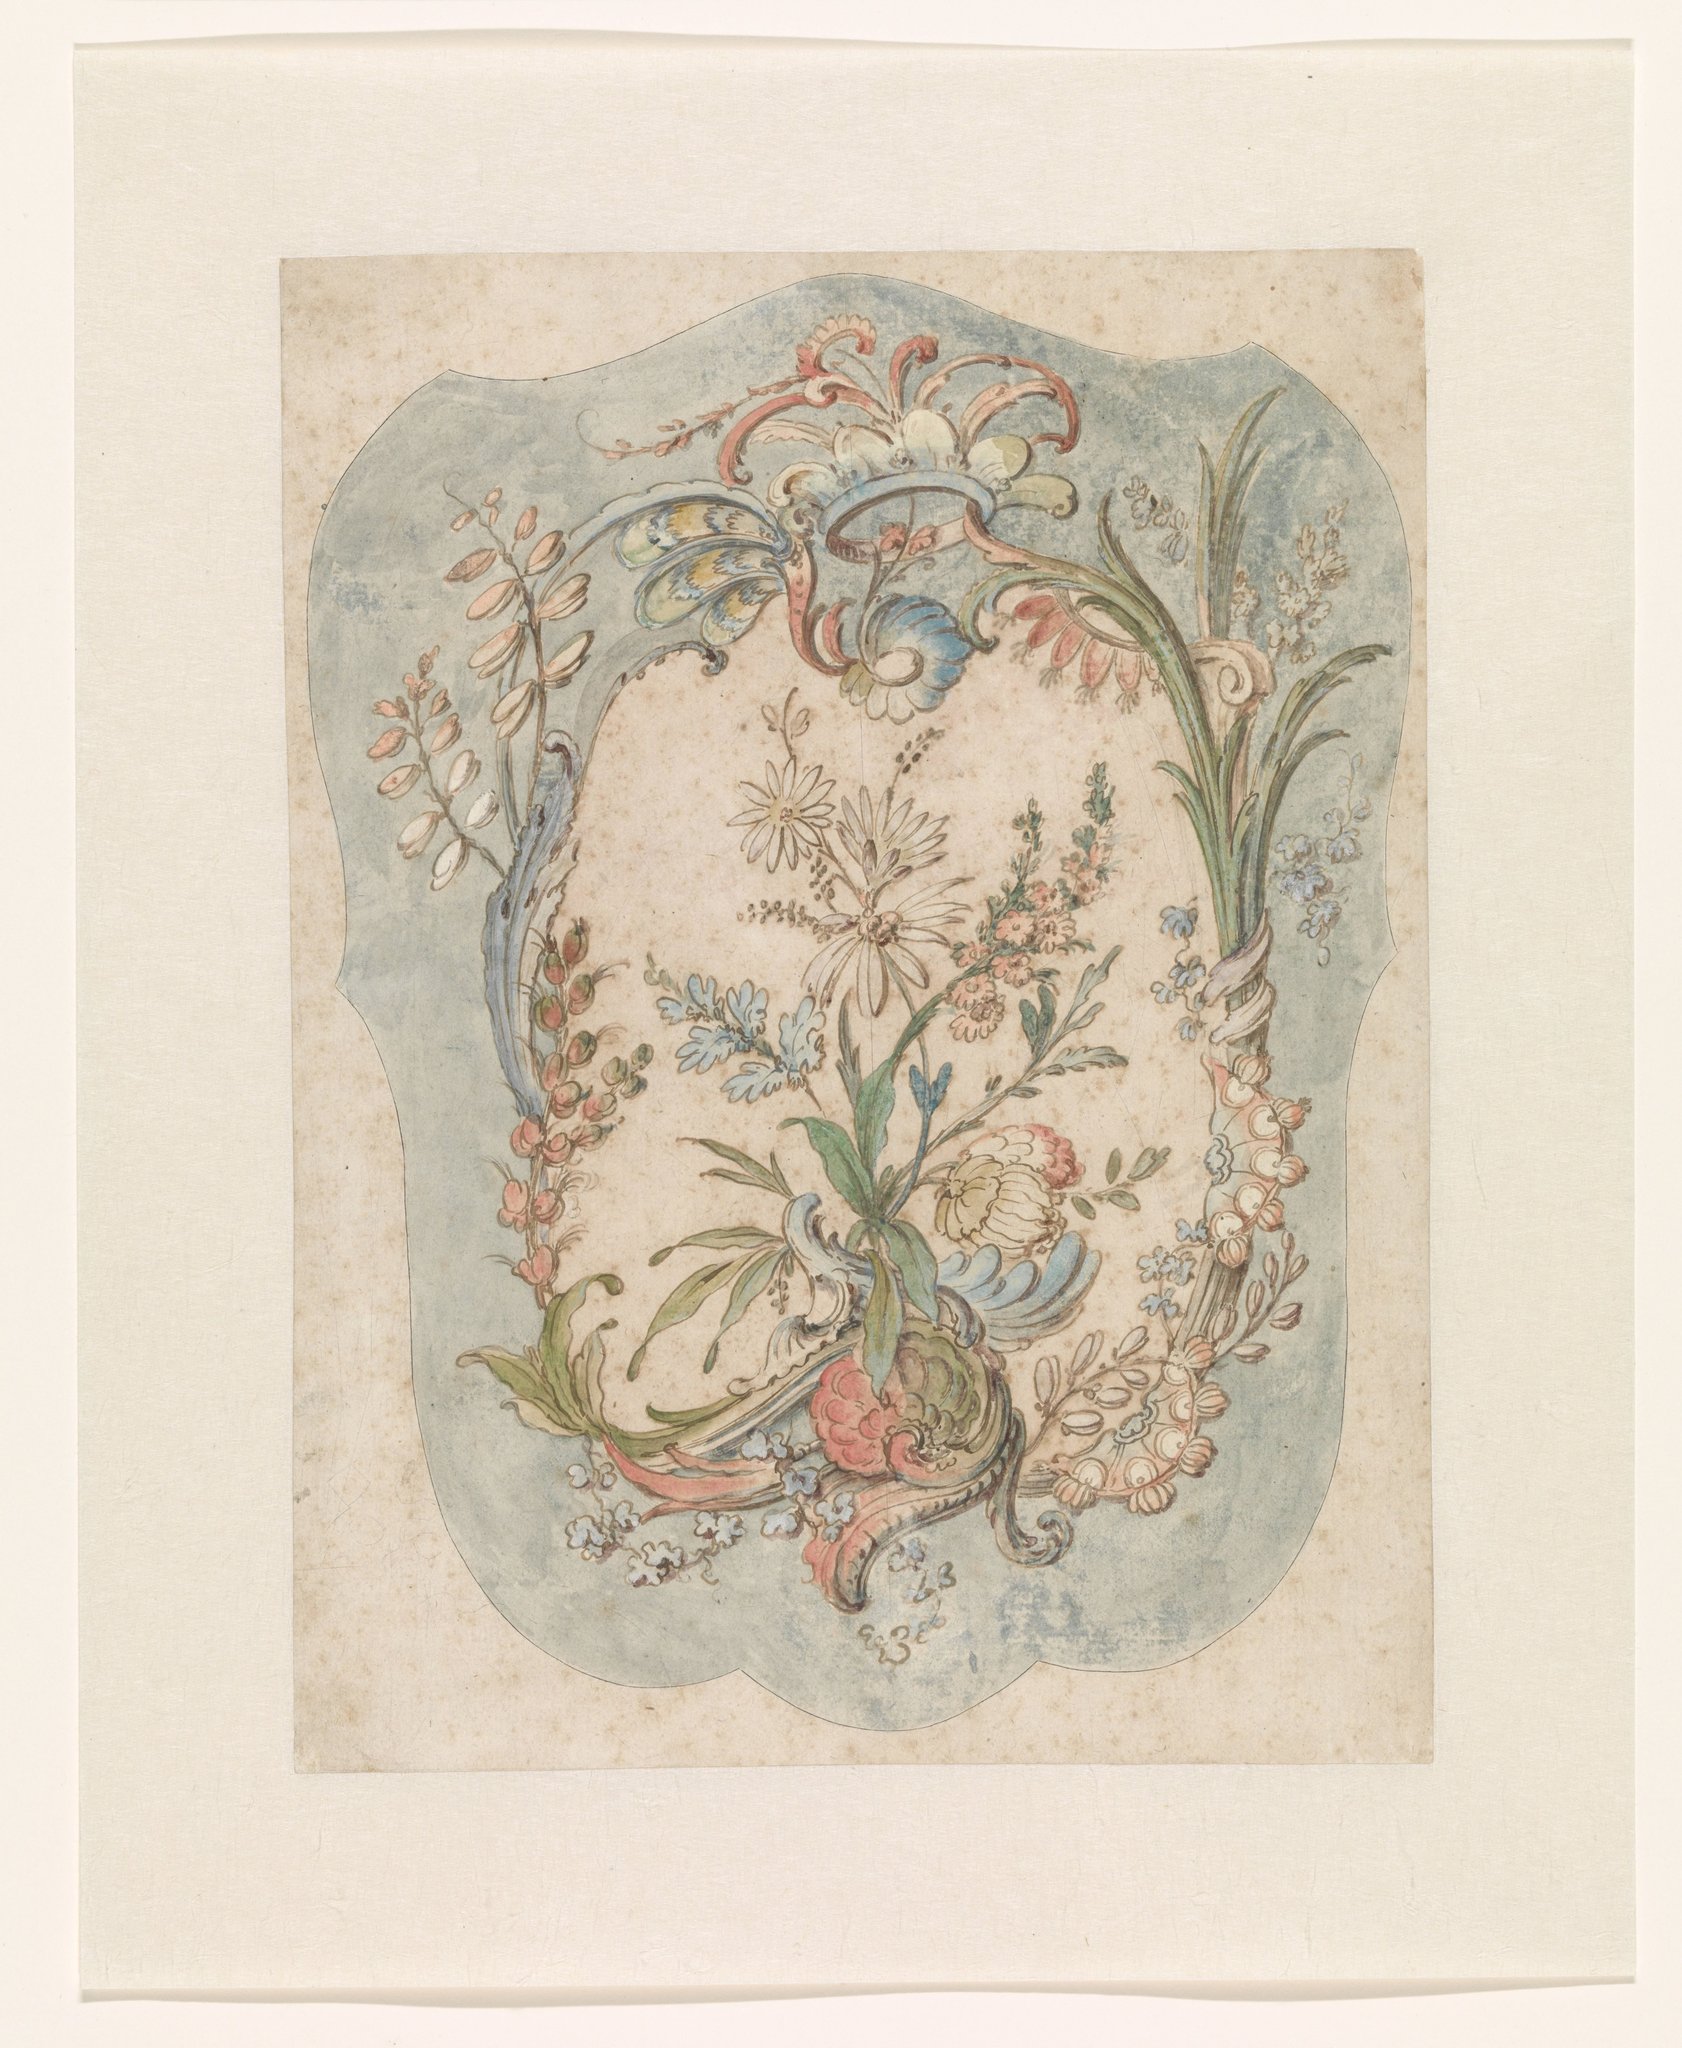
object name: design drawing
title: Design for a hand-screen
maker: gabriel huquier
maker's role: painter, print maker, publisher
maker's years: 1695-1772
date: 1738-1749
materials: ink, paper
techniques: brush, pen, scoring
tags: fire-screen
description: Small hand-screens, mounted on a short handle, were used to protect the face from the heat and glare of an open fire. Their decoration exercised the inventive powers of many rococo artists. Here flowers, foliage, a shell and an insect have been combined into an asymmetrical, ornamental border. Between 1738 and 1749 Huquier published an engraving based on this watercolour.